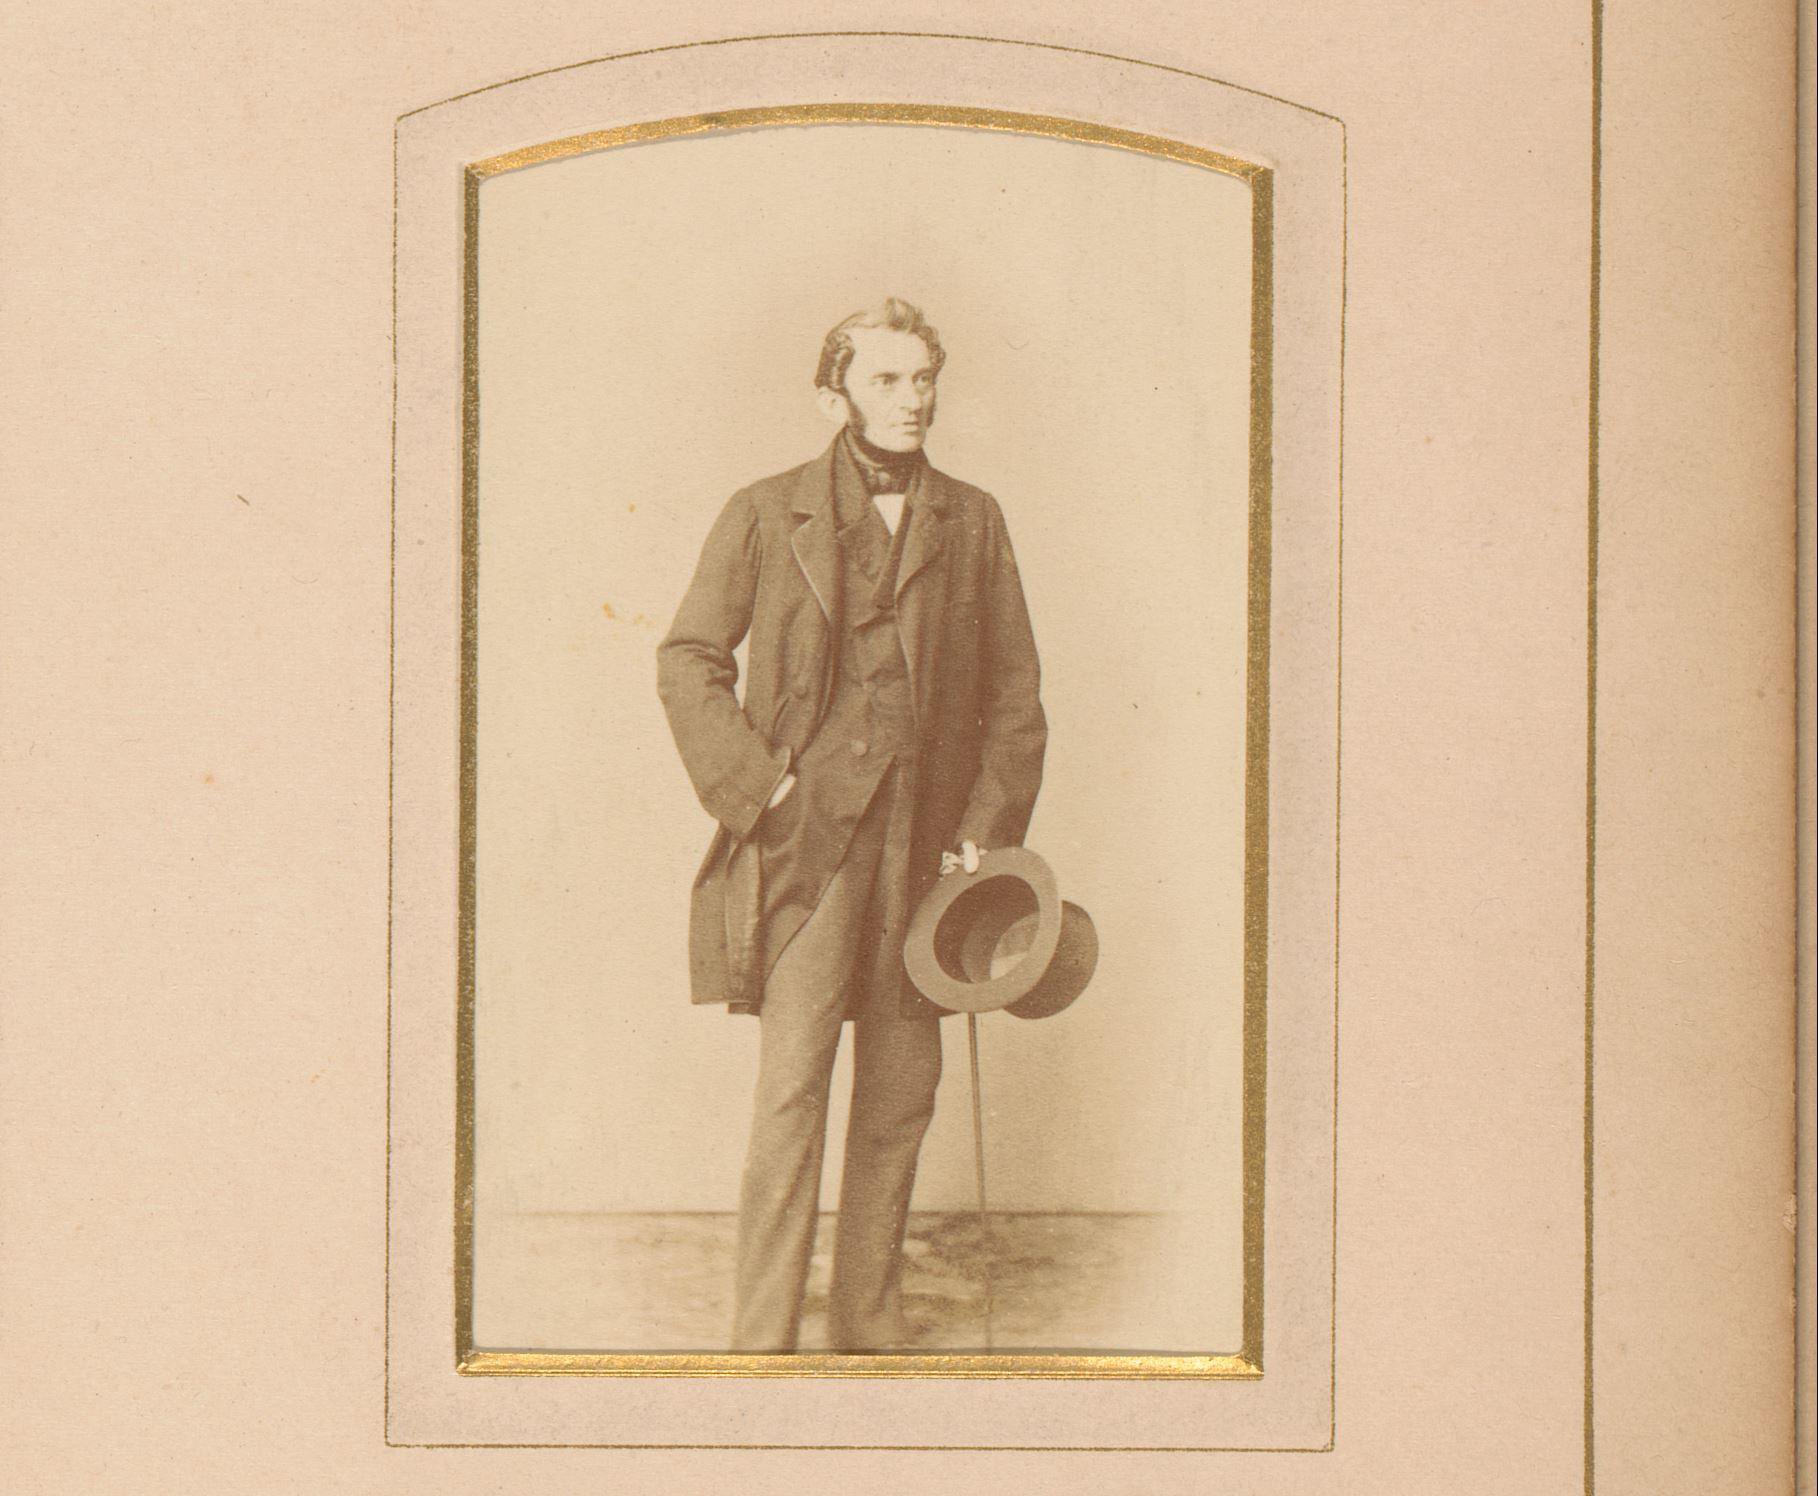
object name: album leaf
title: Portret van Graaf van Bijland, kamerheer van Sophia Frederica Mathilda, koningin der Nederlanden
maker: Anonymous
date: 1850-1877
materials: cardboard, photographic support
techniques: albumen print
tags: historical persons, nobility and patriciate; chivalry, knighthood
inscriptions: annotation: ‘Graaf v. Bijland/ kamerheer van koningin Sophie’, number: ‘10653’